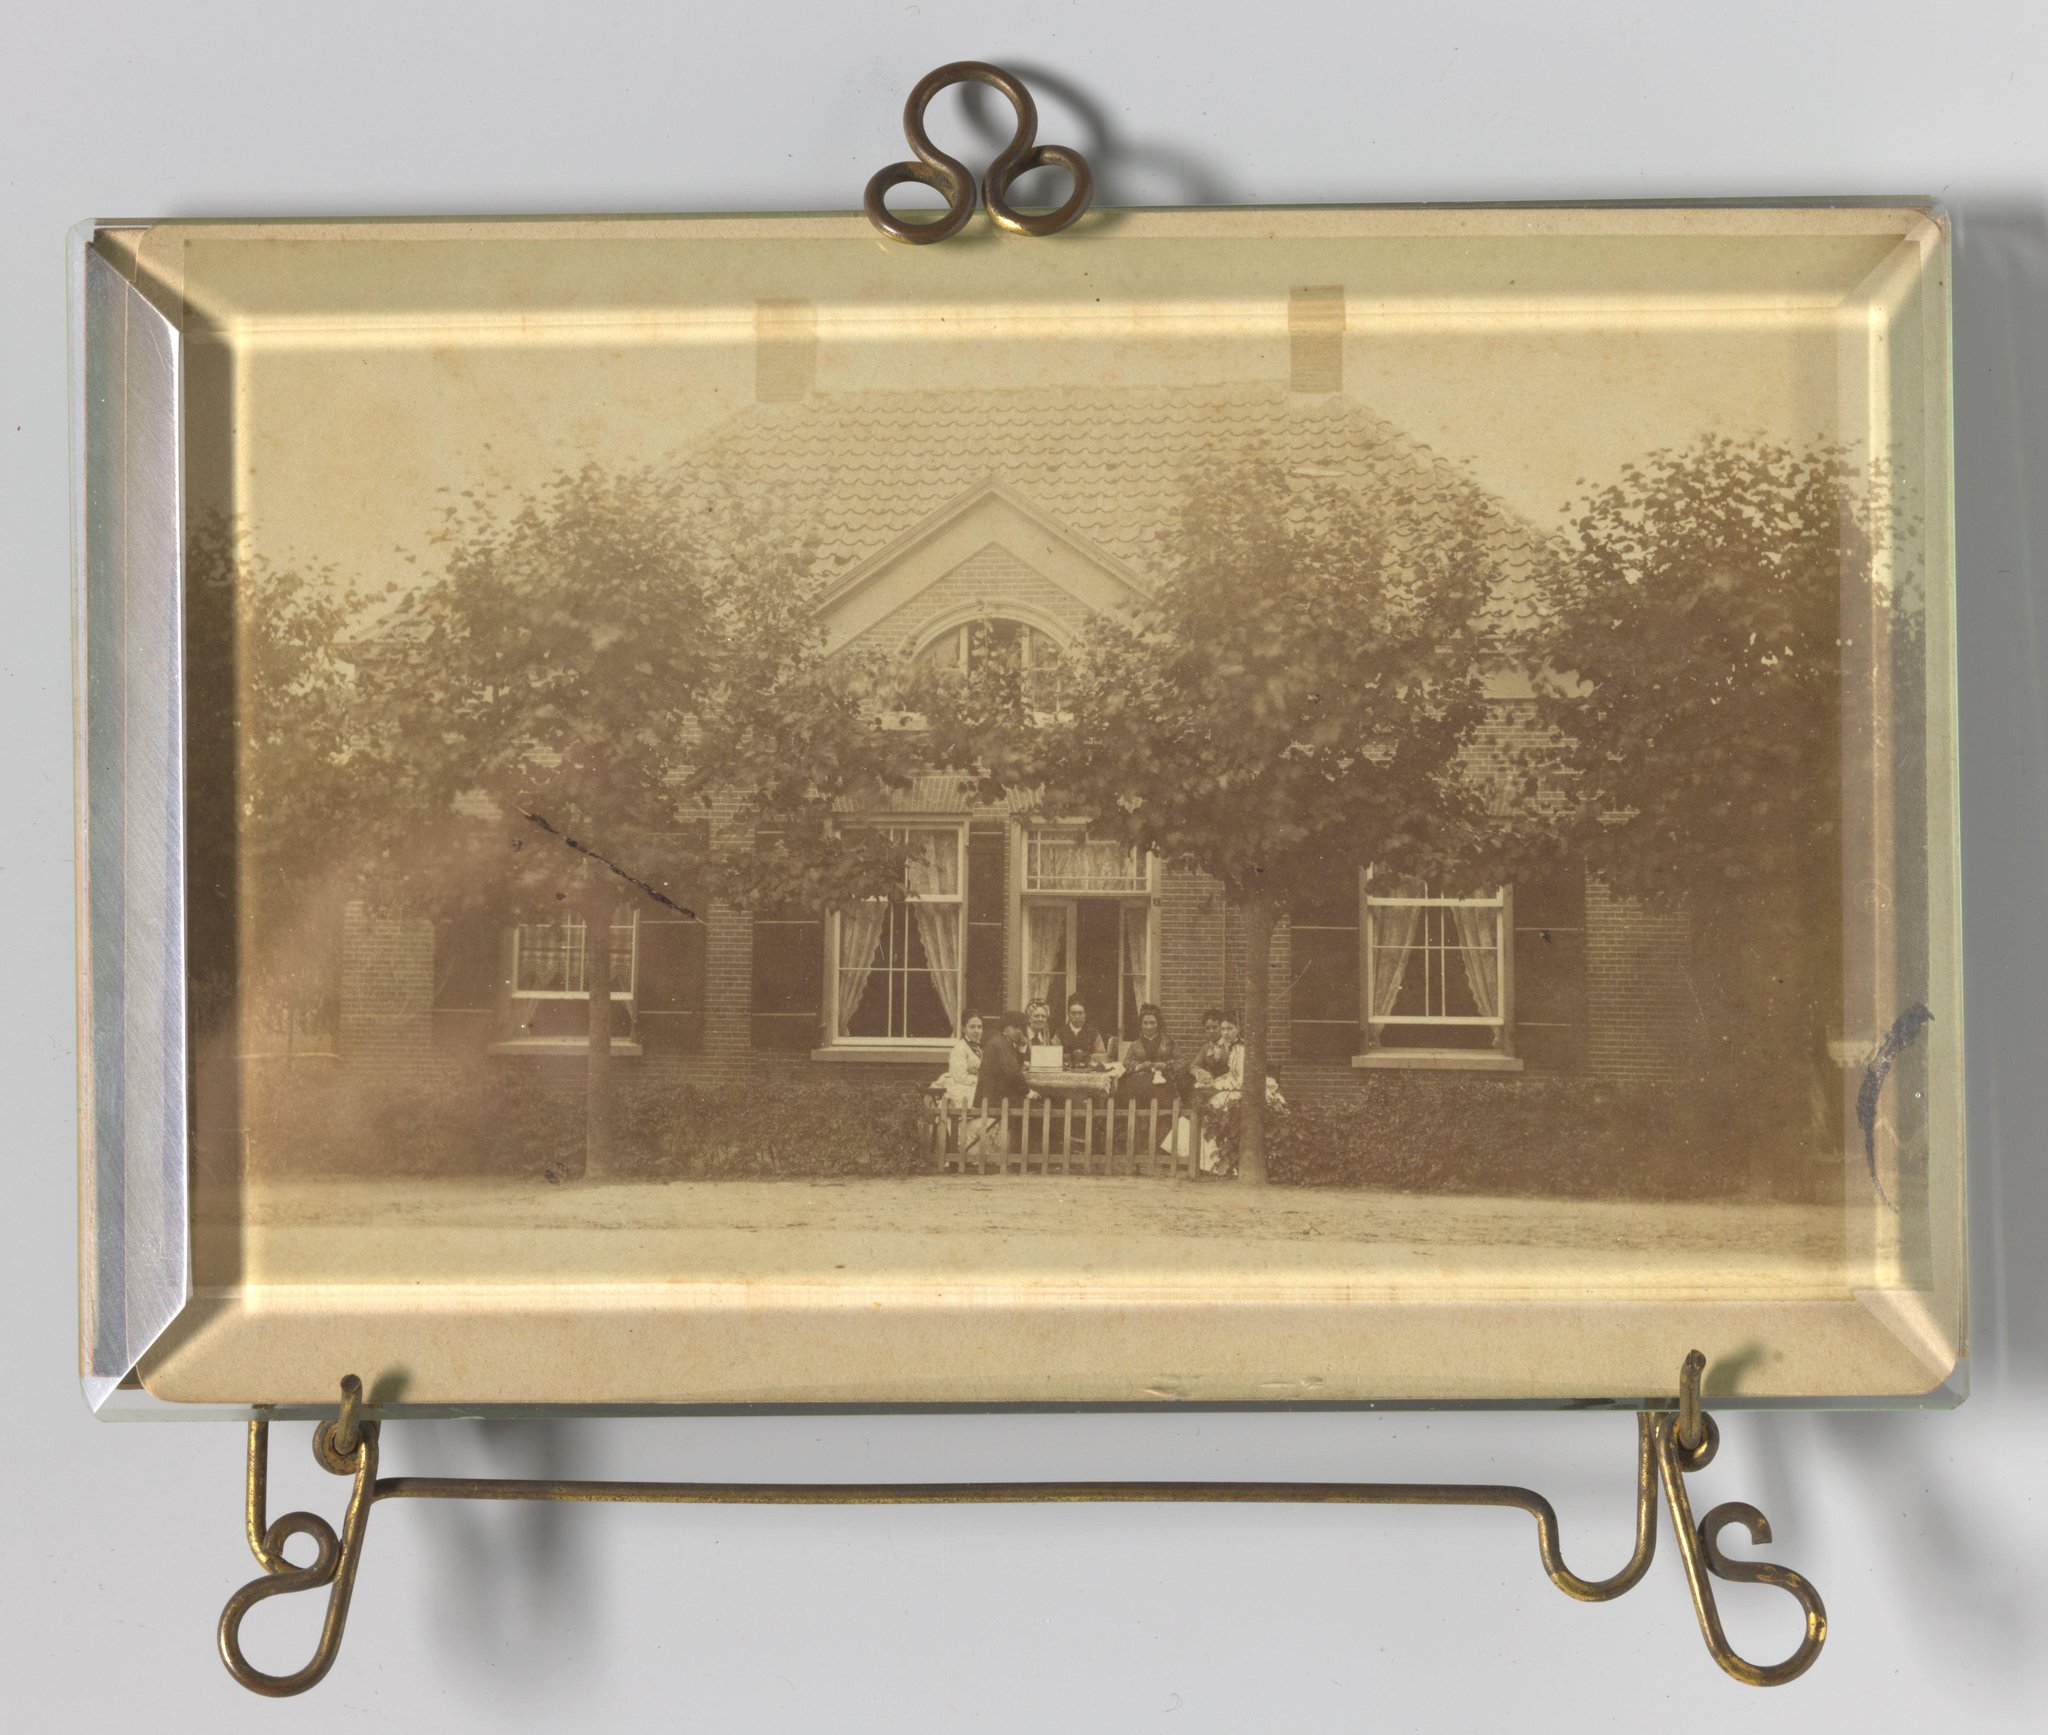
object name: frame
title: Onbekend gezelschap aan tafel voor een huis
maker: Anonymous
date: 1880-1900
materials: cardboard, glass, metal, paper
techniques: albumen print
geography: netherlands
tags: rural housing, e.g. country-house, villa, cottage, (family) meal - cc - out of doors, netherlands